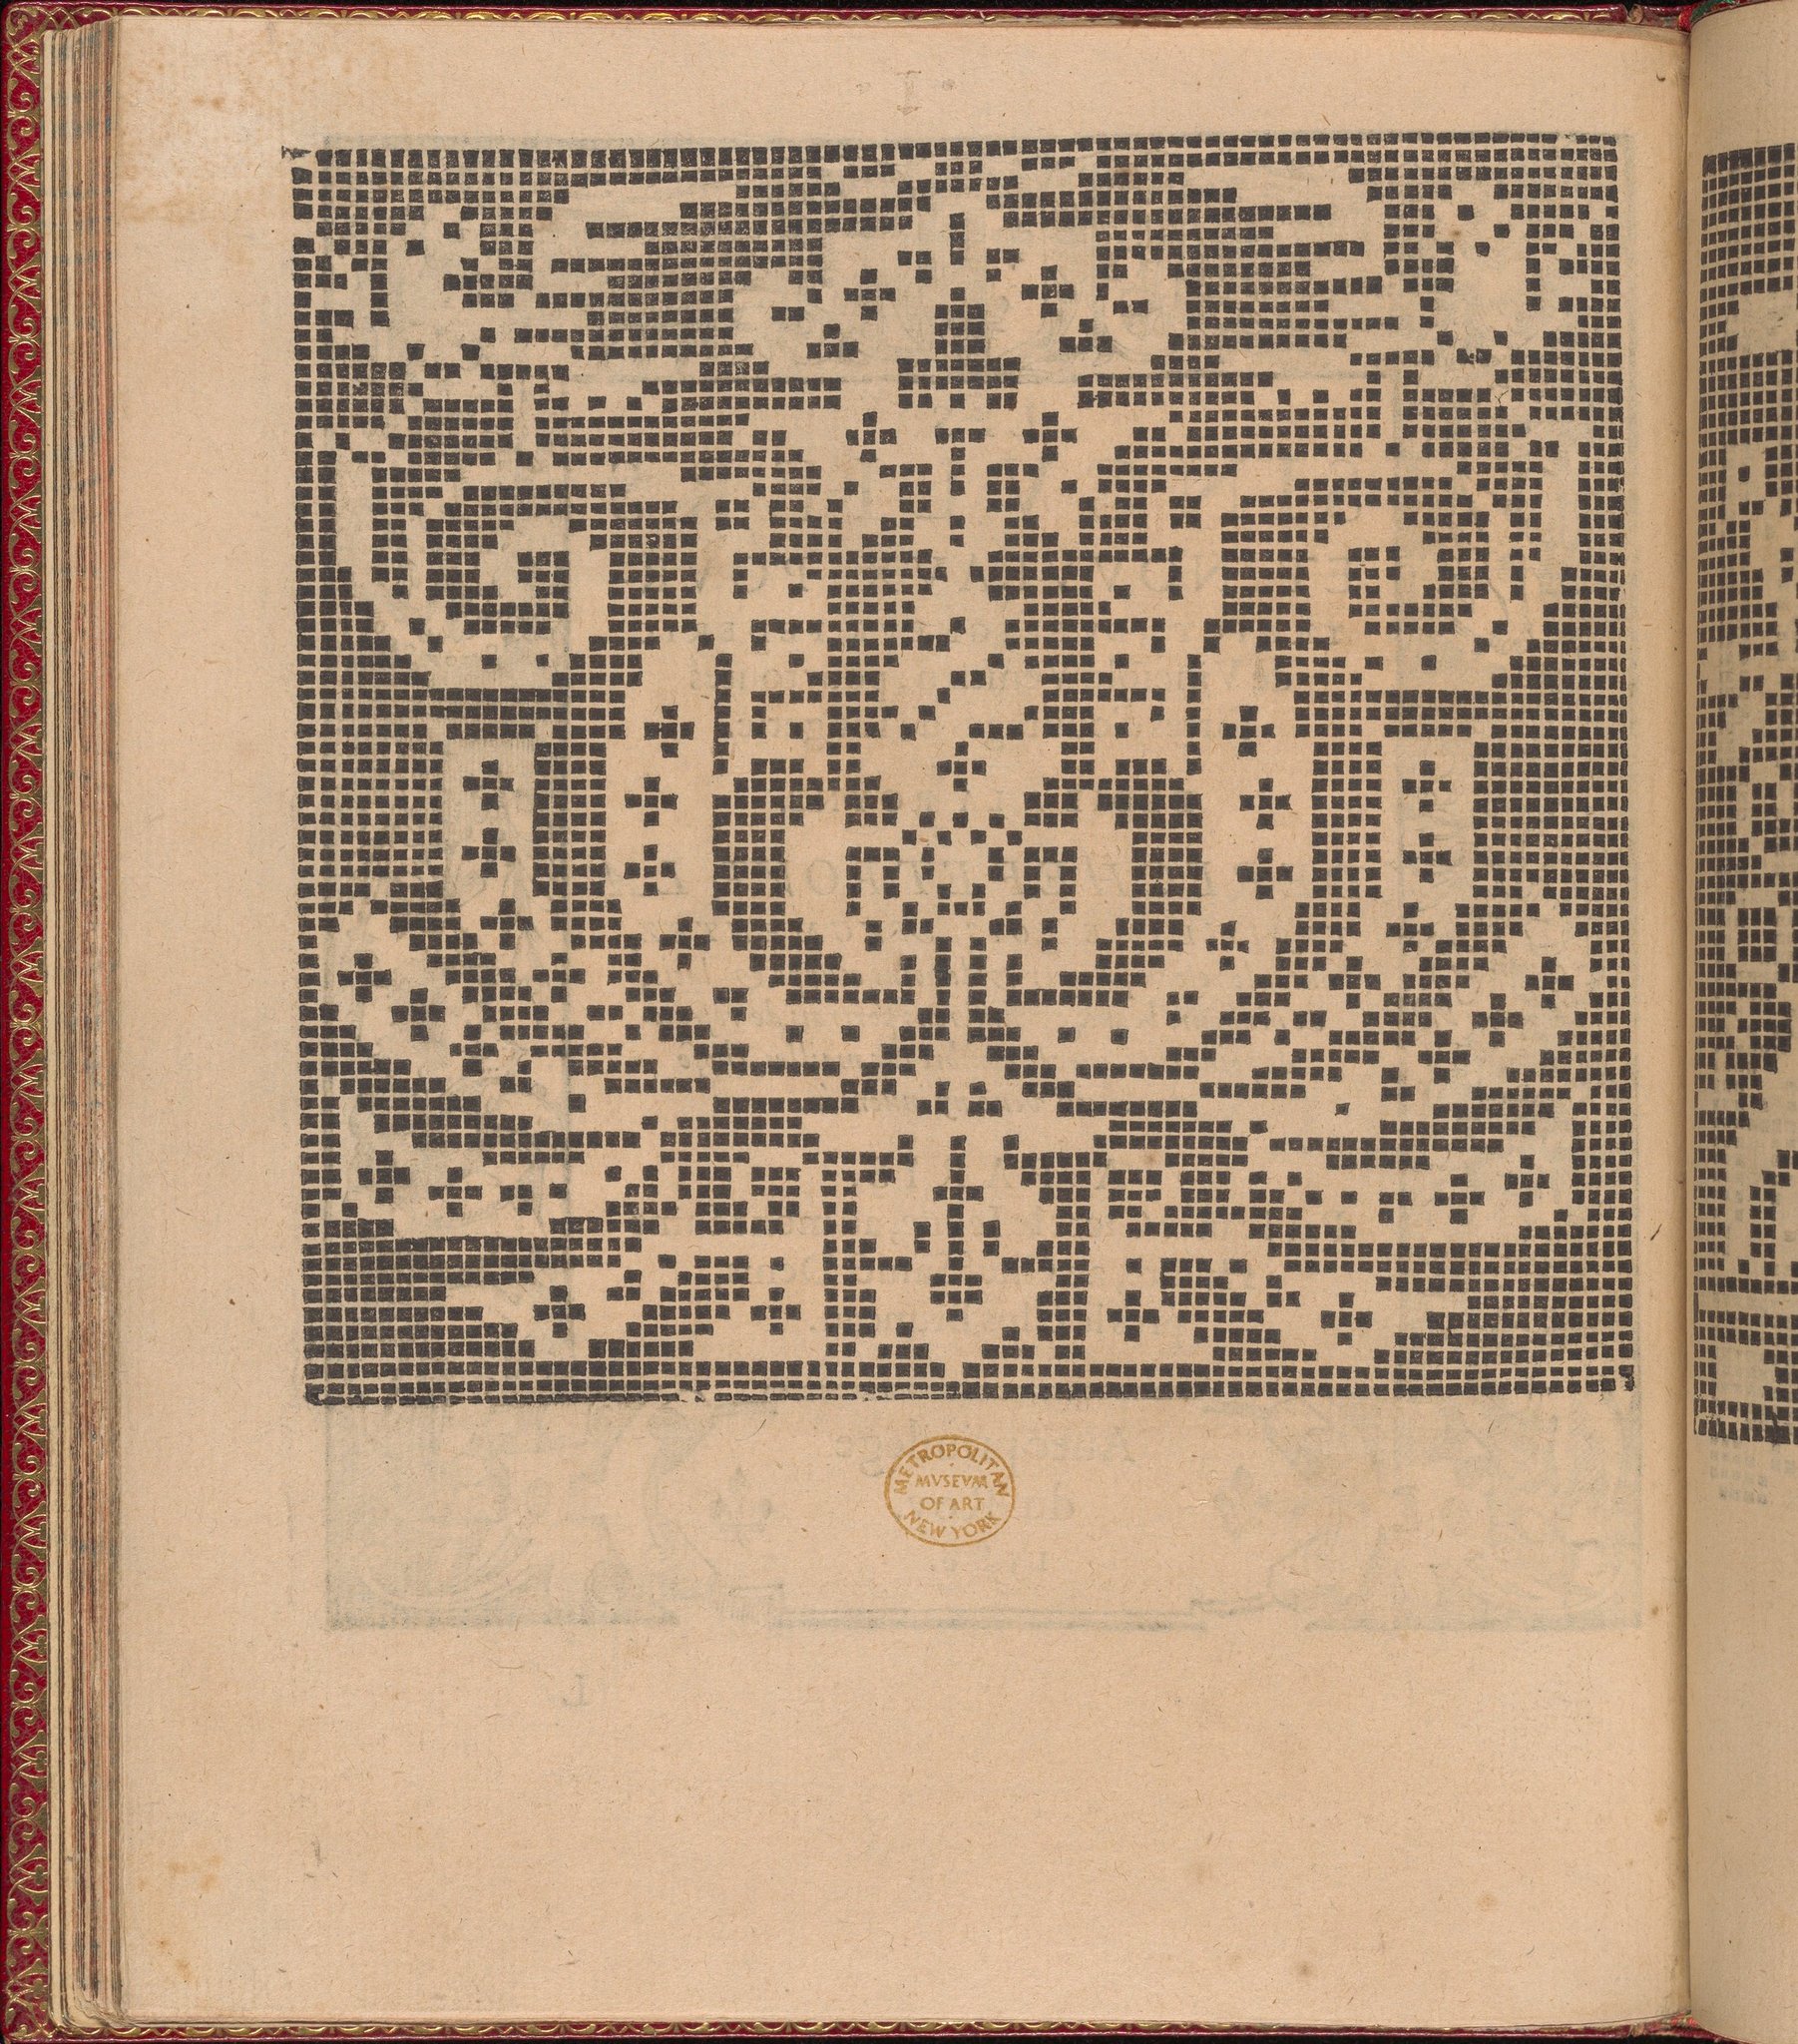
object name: book print ornament architecture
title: Les Singuliers et Nouveaux Portraicts... page 41 (verso)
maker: federico de vinciolo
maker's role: designer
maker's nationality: italian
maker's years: 1582-1599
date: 1588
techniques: woodcut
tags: birds,ornament